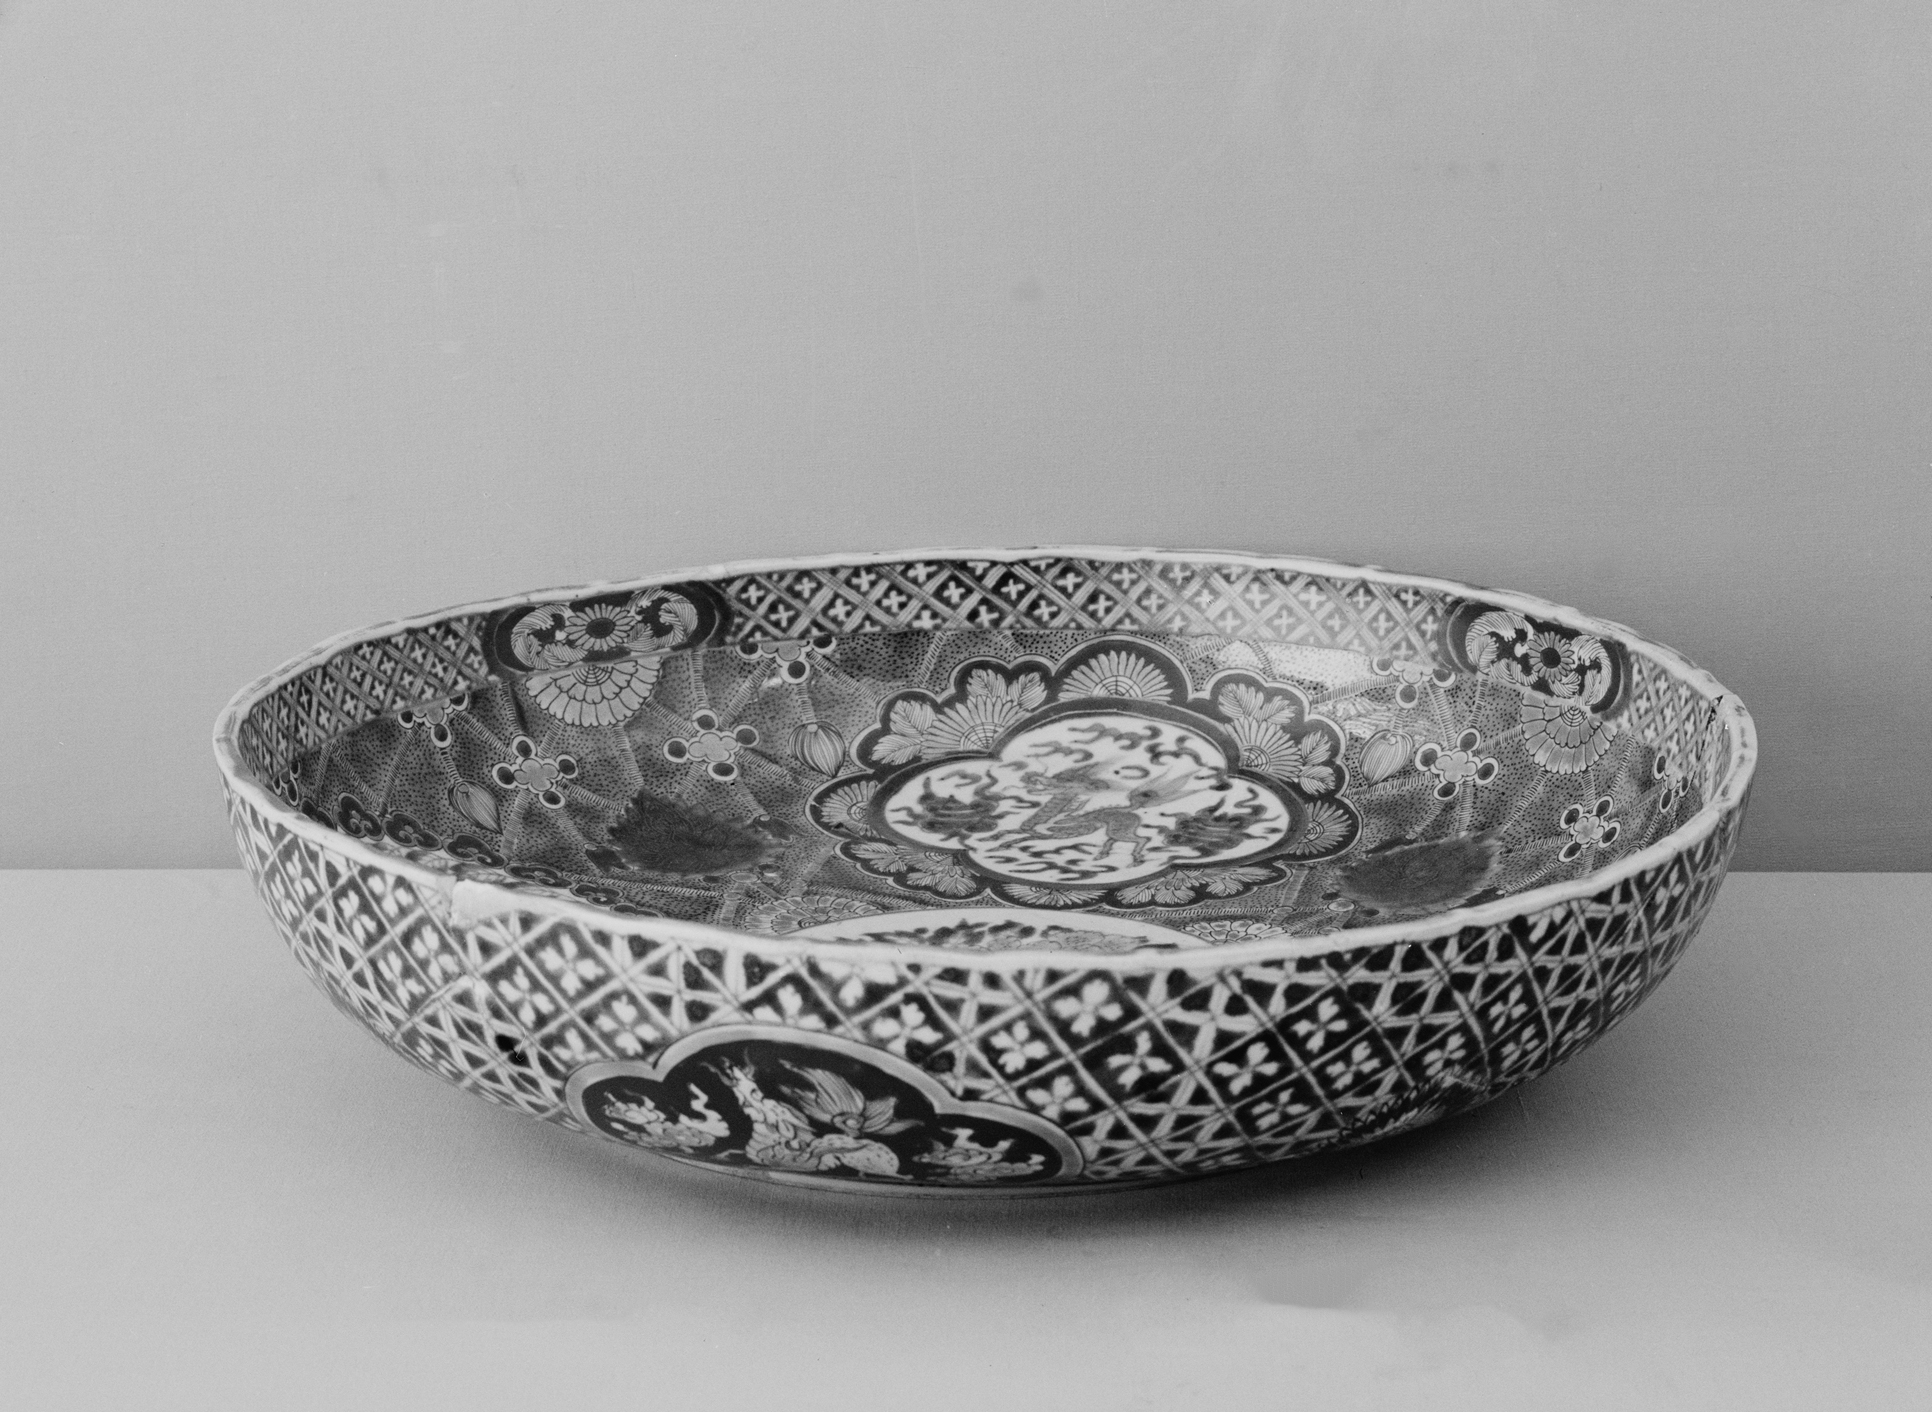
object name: dish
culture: japanese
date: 1750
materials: enamel, glaze, porcelain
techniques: polychrome